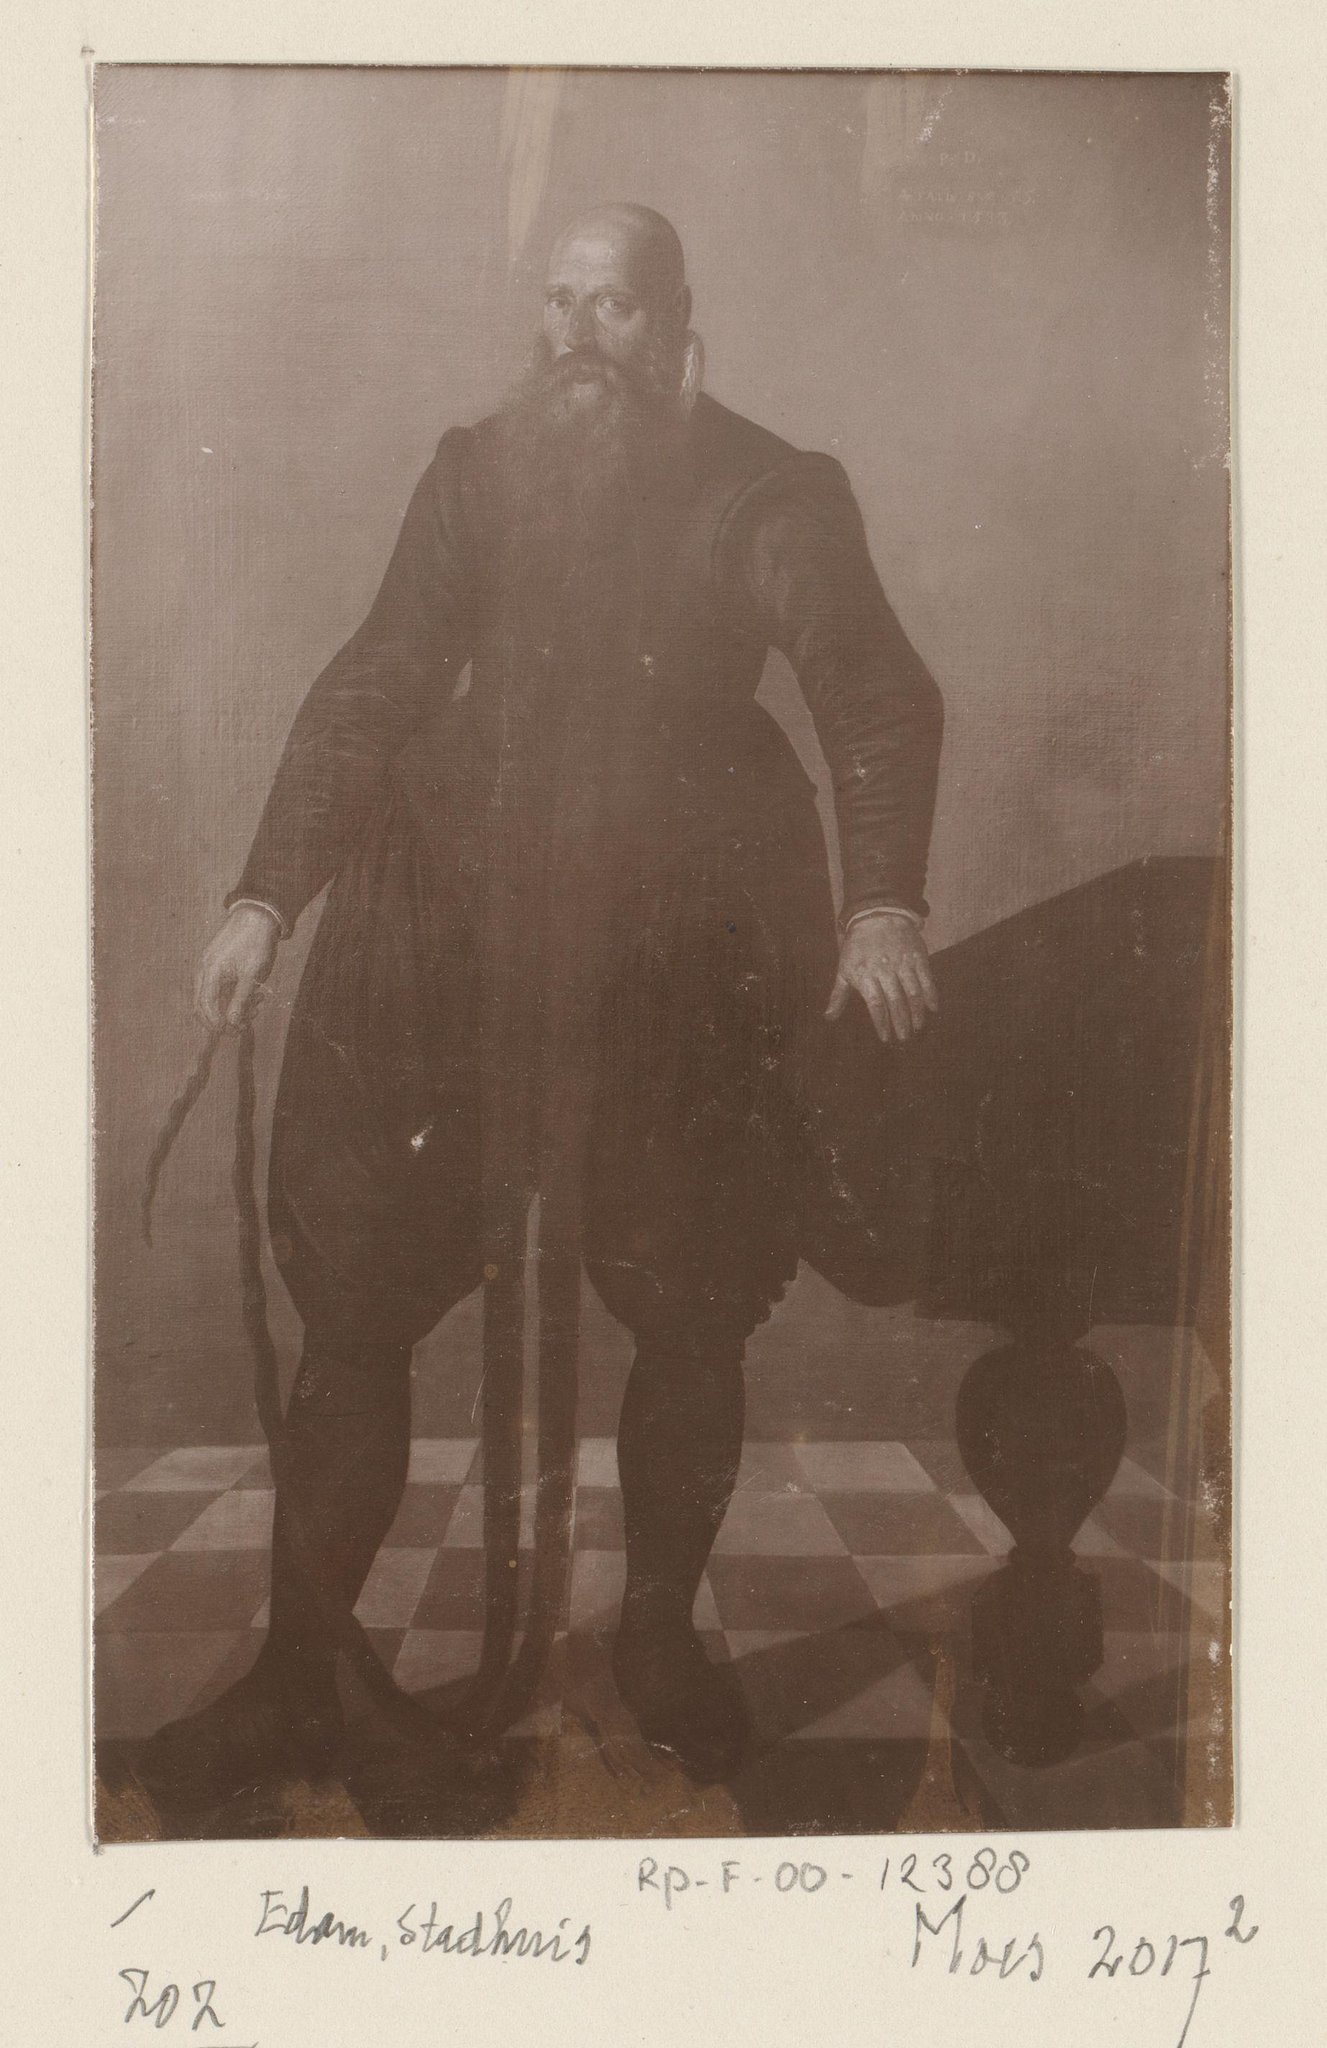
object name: photograph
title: Fotoreproductie van een geschilderd portret van Pieter Dircksz. Langbaard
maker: Anonymous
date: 1880-1900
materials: paper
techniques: gelatin silver print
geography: edam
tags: historical persons, picture, painting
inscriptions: inscription: ‘Pieter Dircksz (Burgemeester)/ bijgenaamd Langebaart/ naar de schilderij op het stad/ huis te Edam/ Boven aan staat:/ P.D./ actatis suac/ 53 - Anno/ 1583’